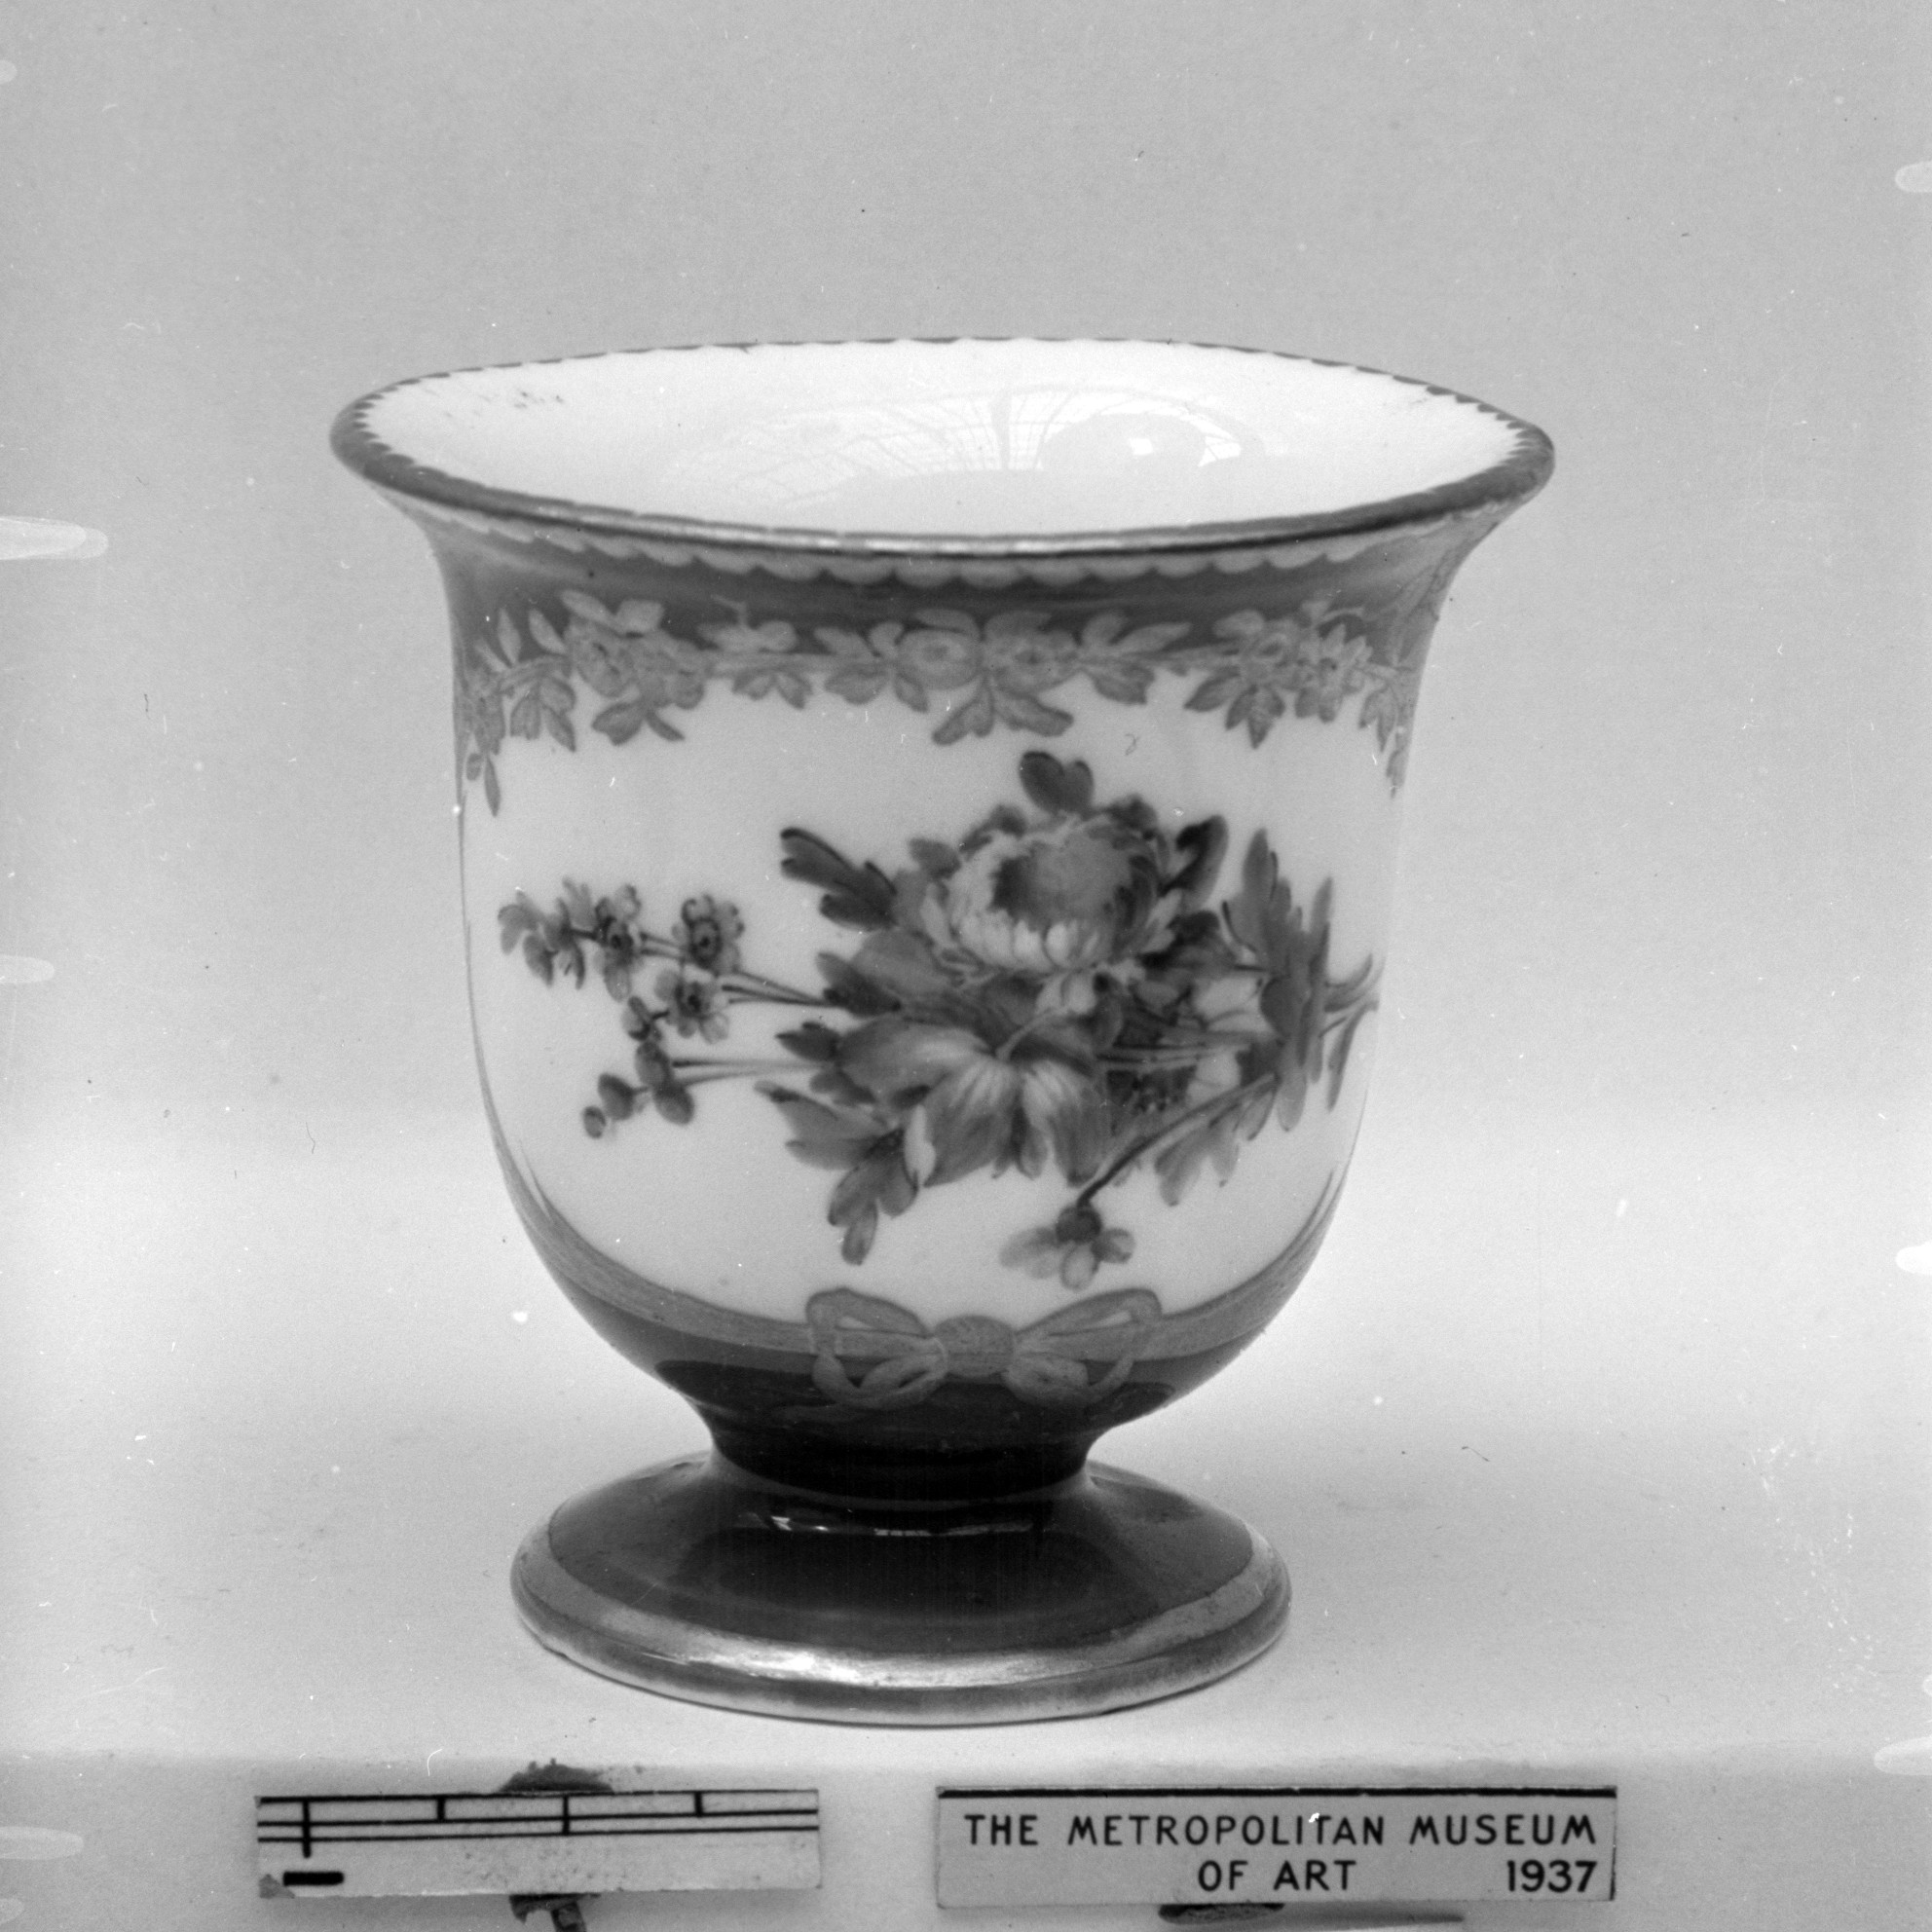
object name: ice cream cup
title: Ice cream cup (Tasse à glace) (part of a service)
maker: sèvres manufactory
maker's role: manufactory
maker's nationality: french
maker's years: 1740-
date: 1780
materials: soft paste porcelain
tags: flowers